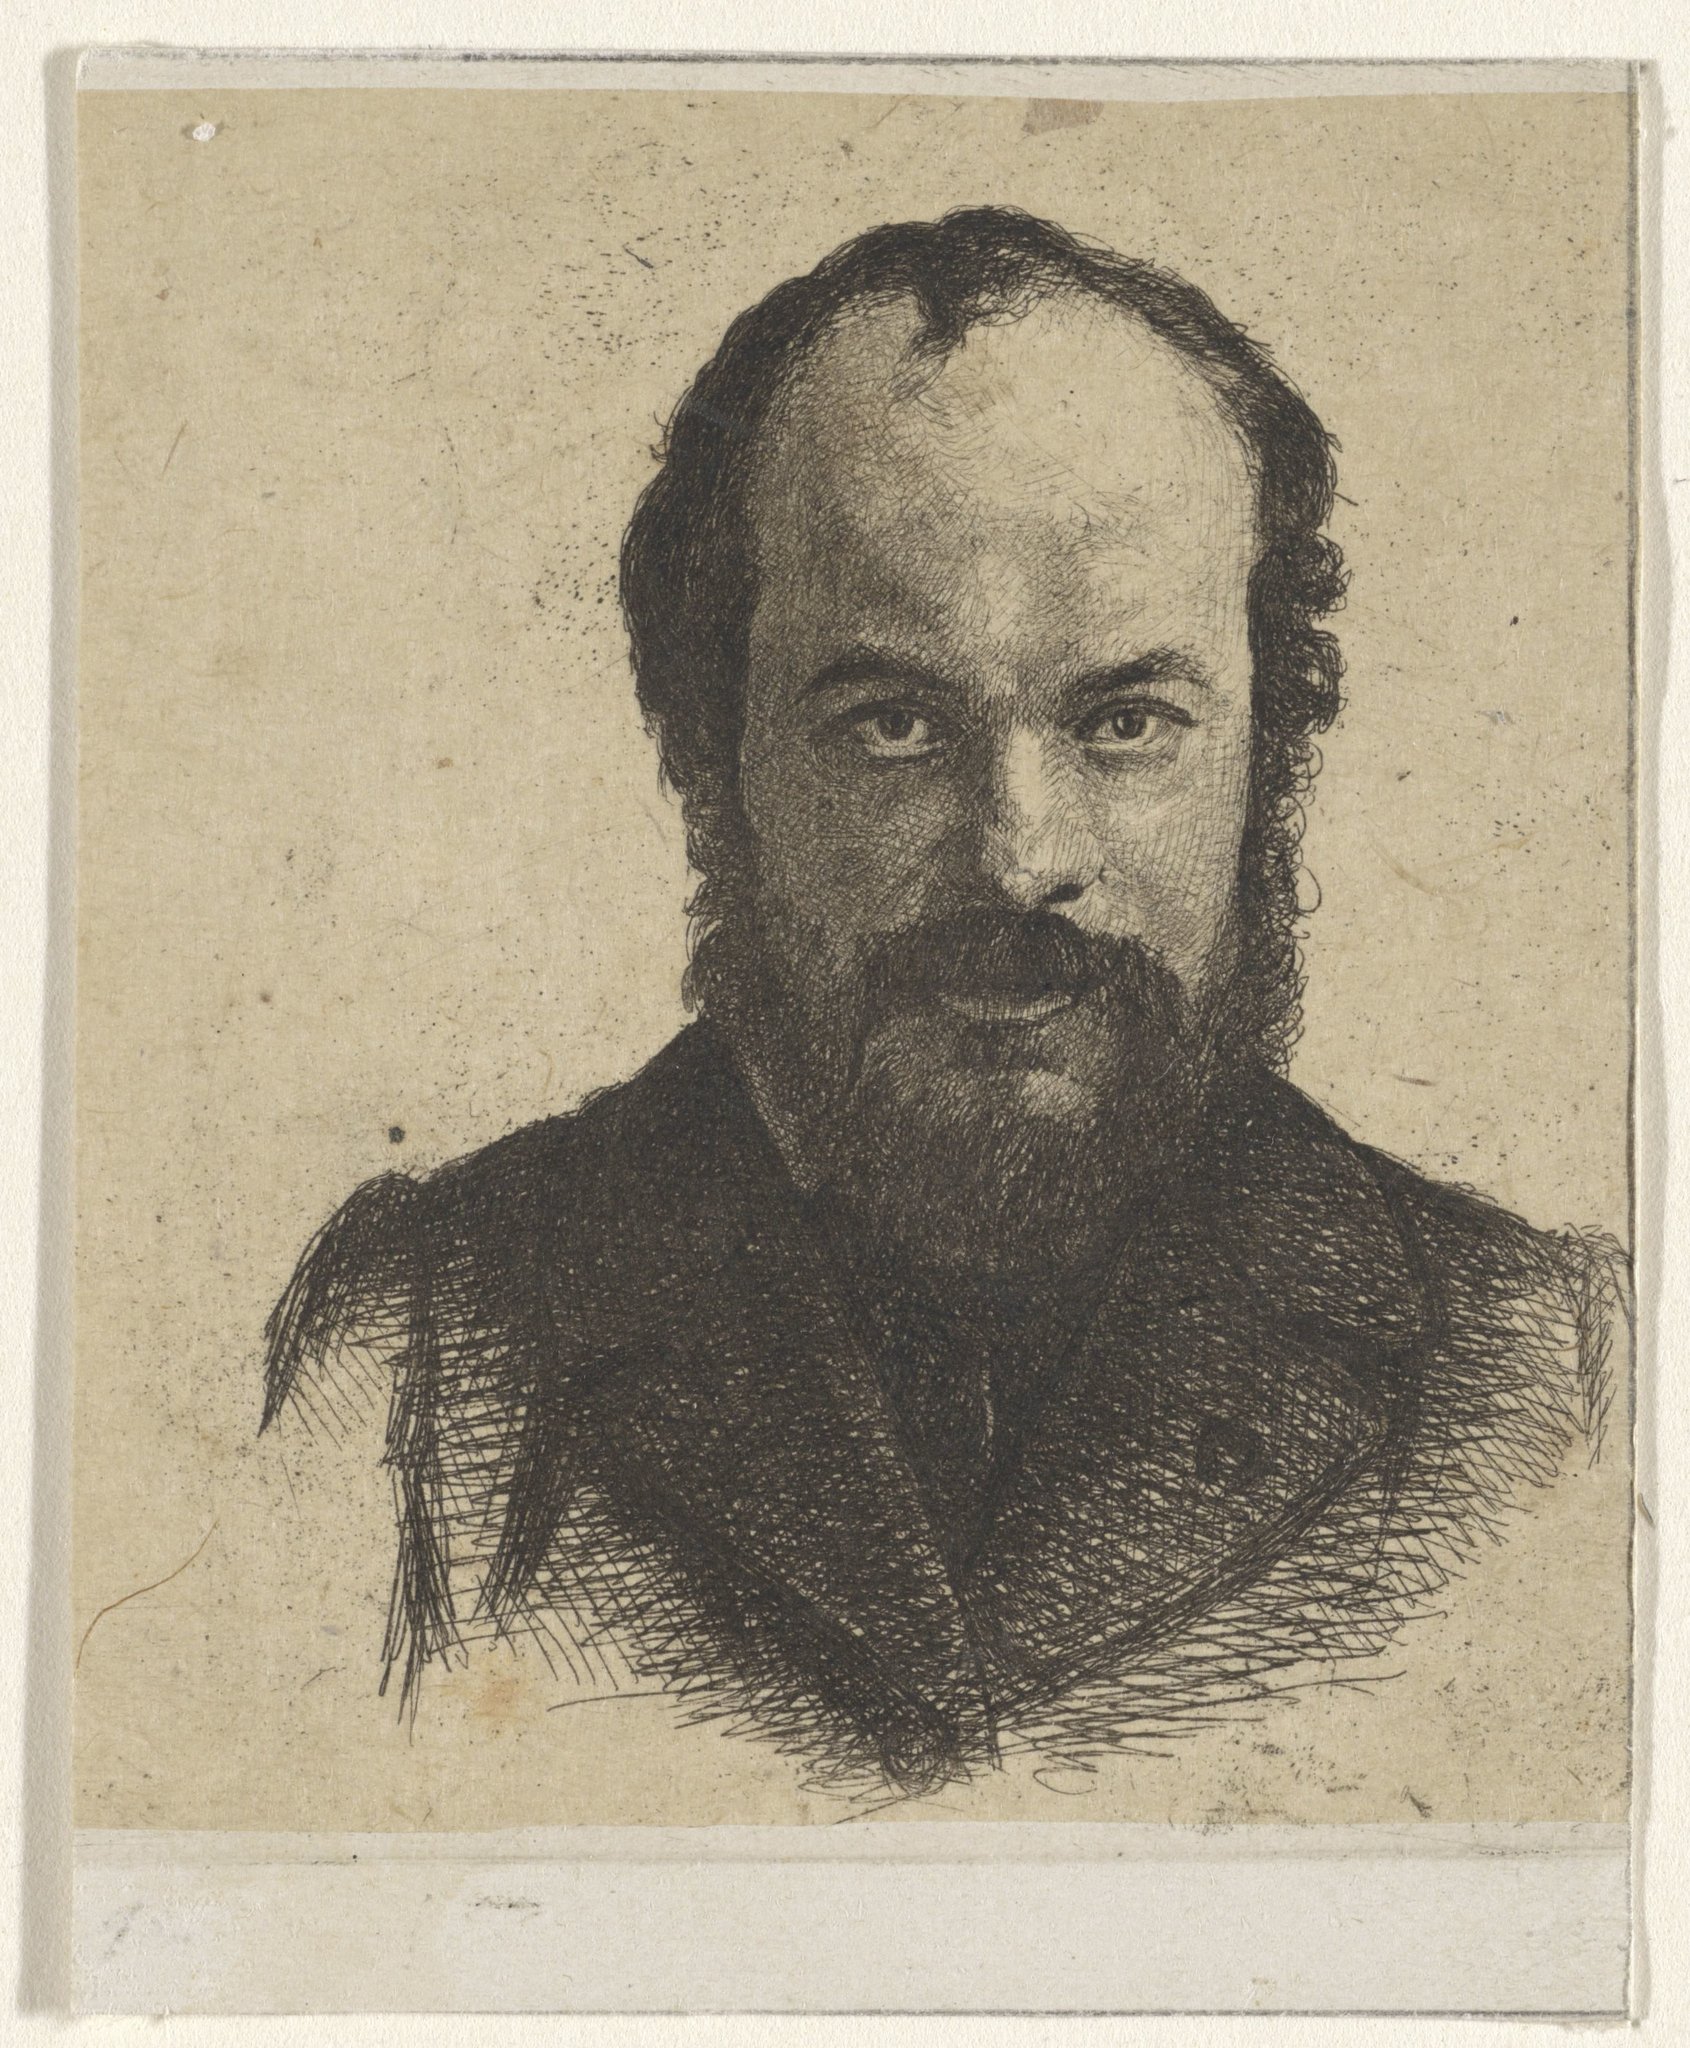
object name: print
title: Portret van Jan Weissenbruch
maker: frederik hendrik weissenbruch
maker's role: draughtsman, print maker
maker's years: 1828-1887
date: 1863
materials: paper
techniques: drypoint, etching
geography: the hague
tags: the hague, painter, print maker, jan weissenbruch, historical persons, portrait, self-portrait of artist, beard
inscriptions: collector's mark: Lugt 2228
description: Portret van de kunstenaar Jan Weissenbruch, oudere broer en leermeester van de vervaardigend kunstenaar.